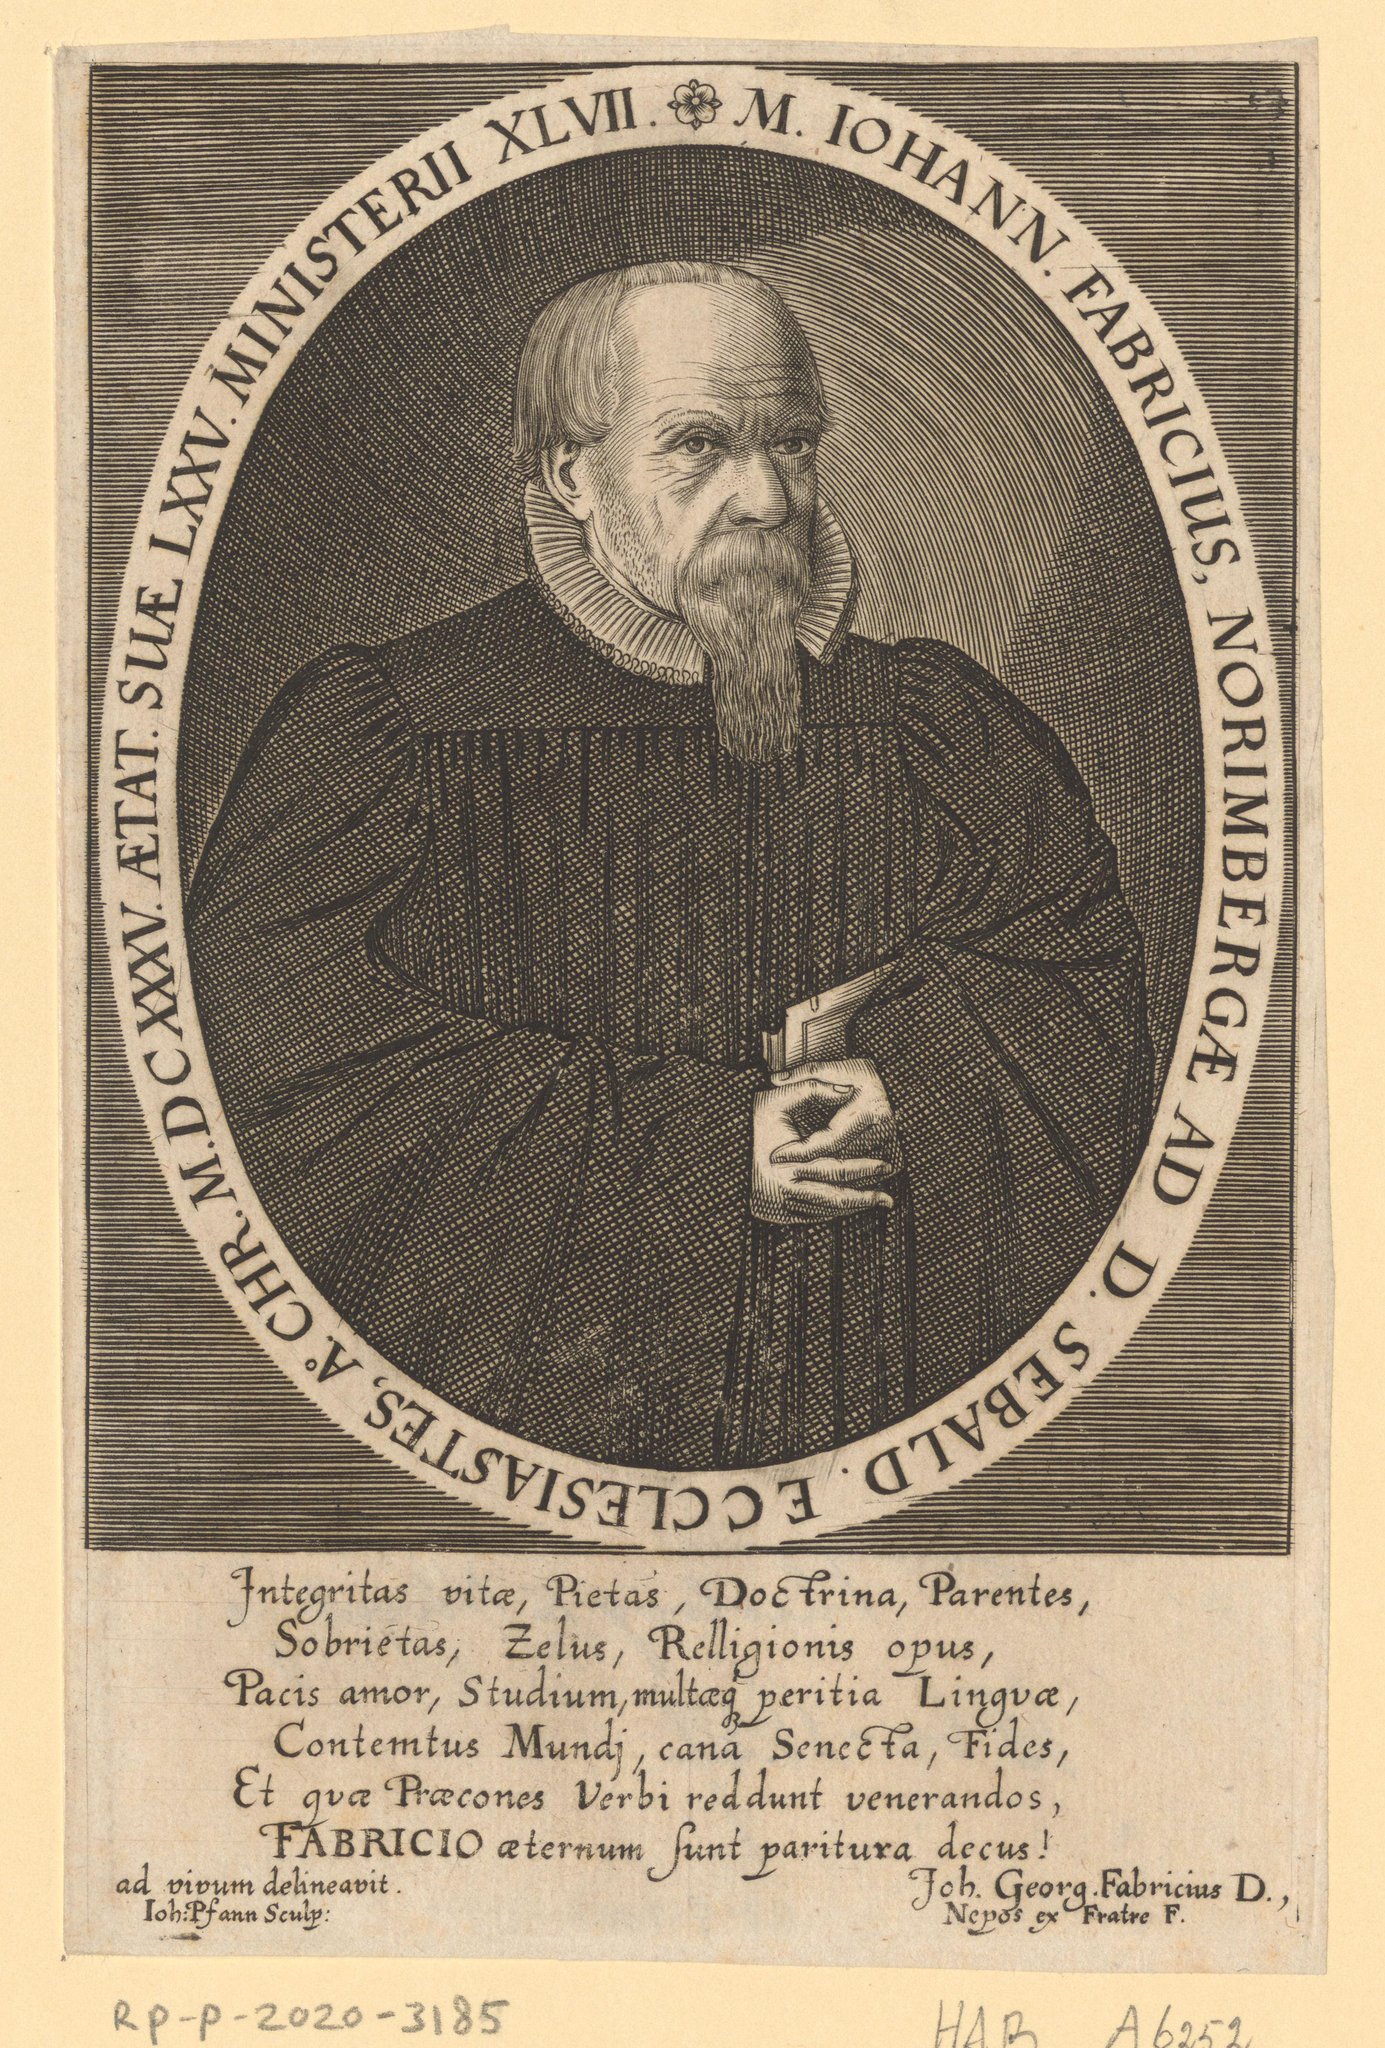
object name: print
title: Portret van Johann Fabricius op 47-jarige leeftijd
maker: johann pfann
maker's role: print maker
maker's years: 1640-1680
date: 1648-1663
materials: paper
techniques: engraving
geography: nuremberg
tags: theologian, historical persons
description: Met zesregelig vers in het Latijn onder het portret.